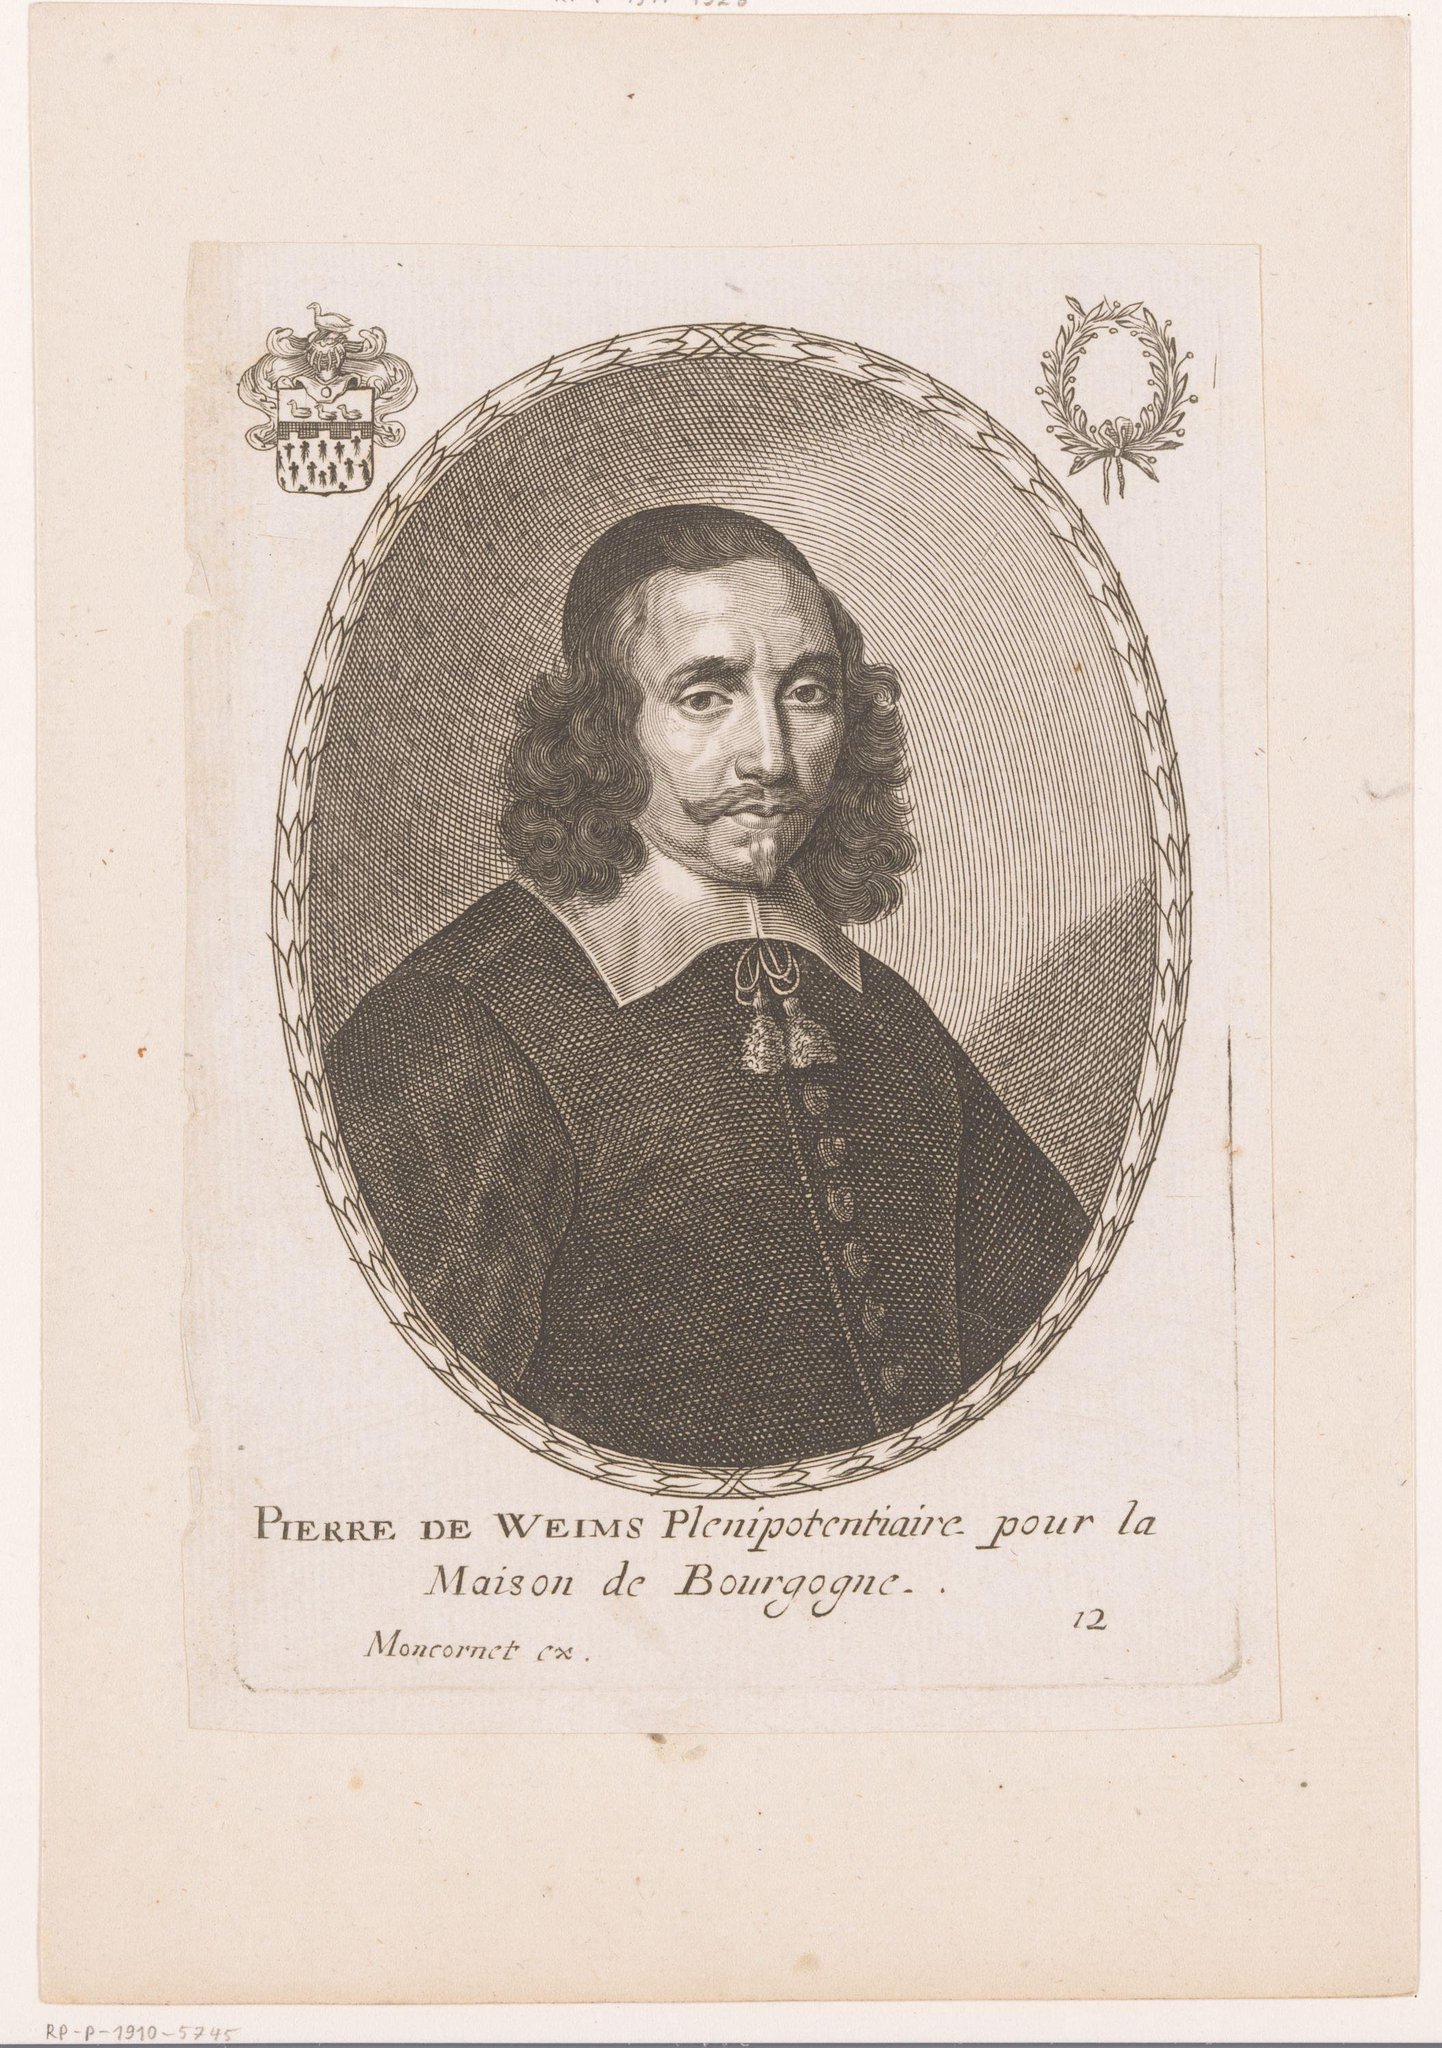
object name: print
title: Portret van Pierre de Weims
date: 1610-1668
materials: paper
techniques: engraving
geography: paris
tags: historical persons, armorial bearing, heraldry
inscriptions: collector's mark: Lugt 2228